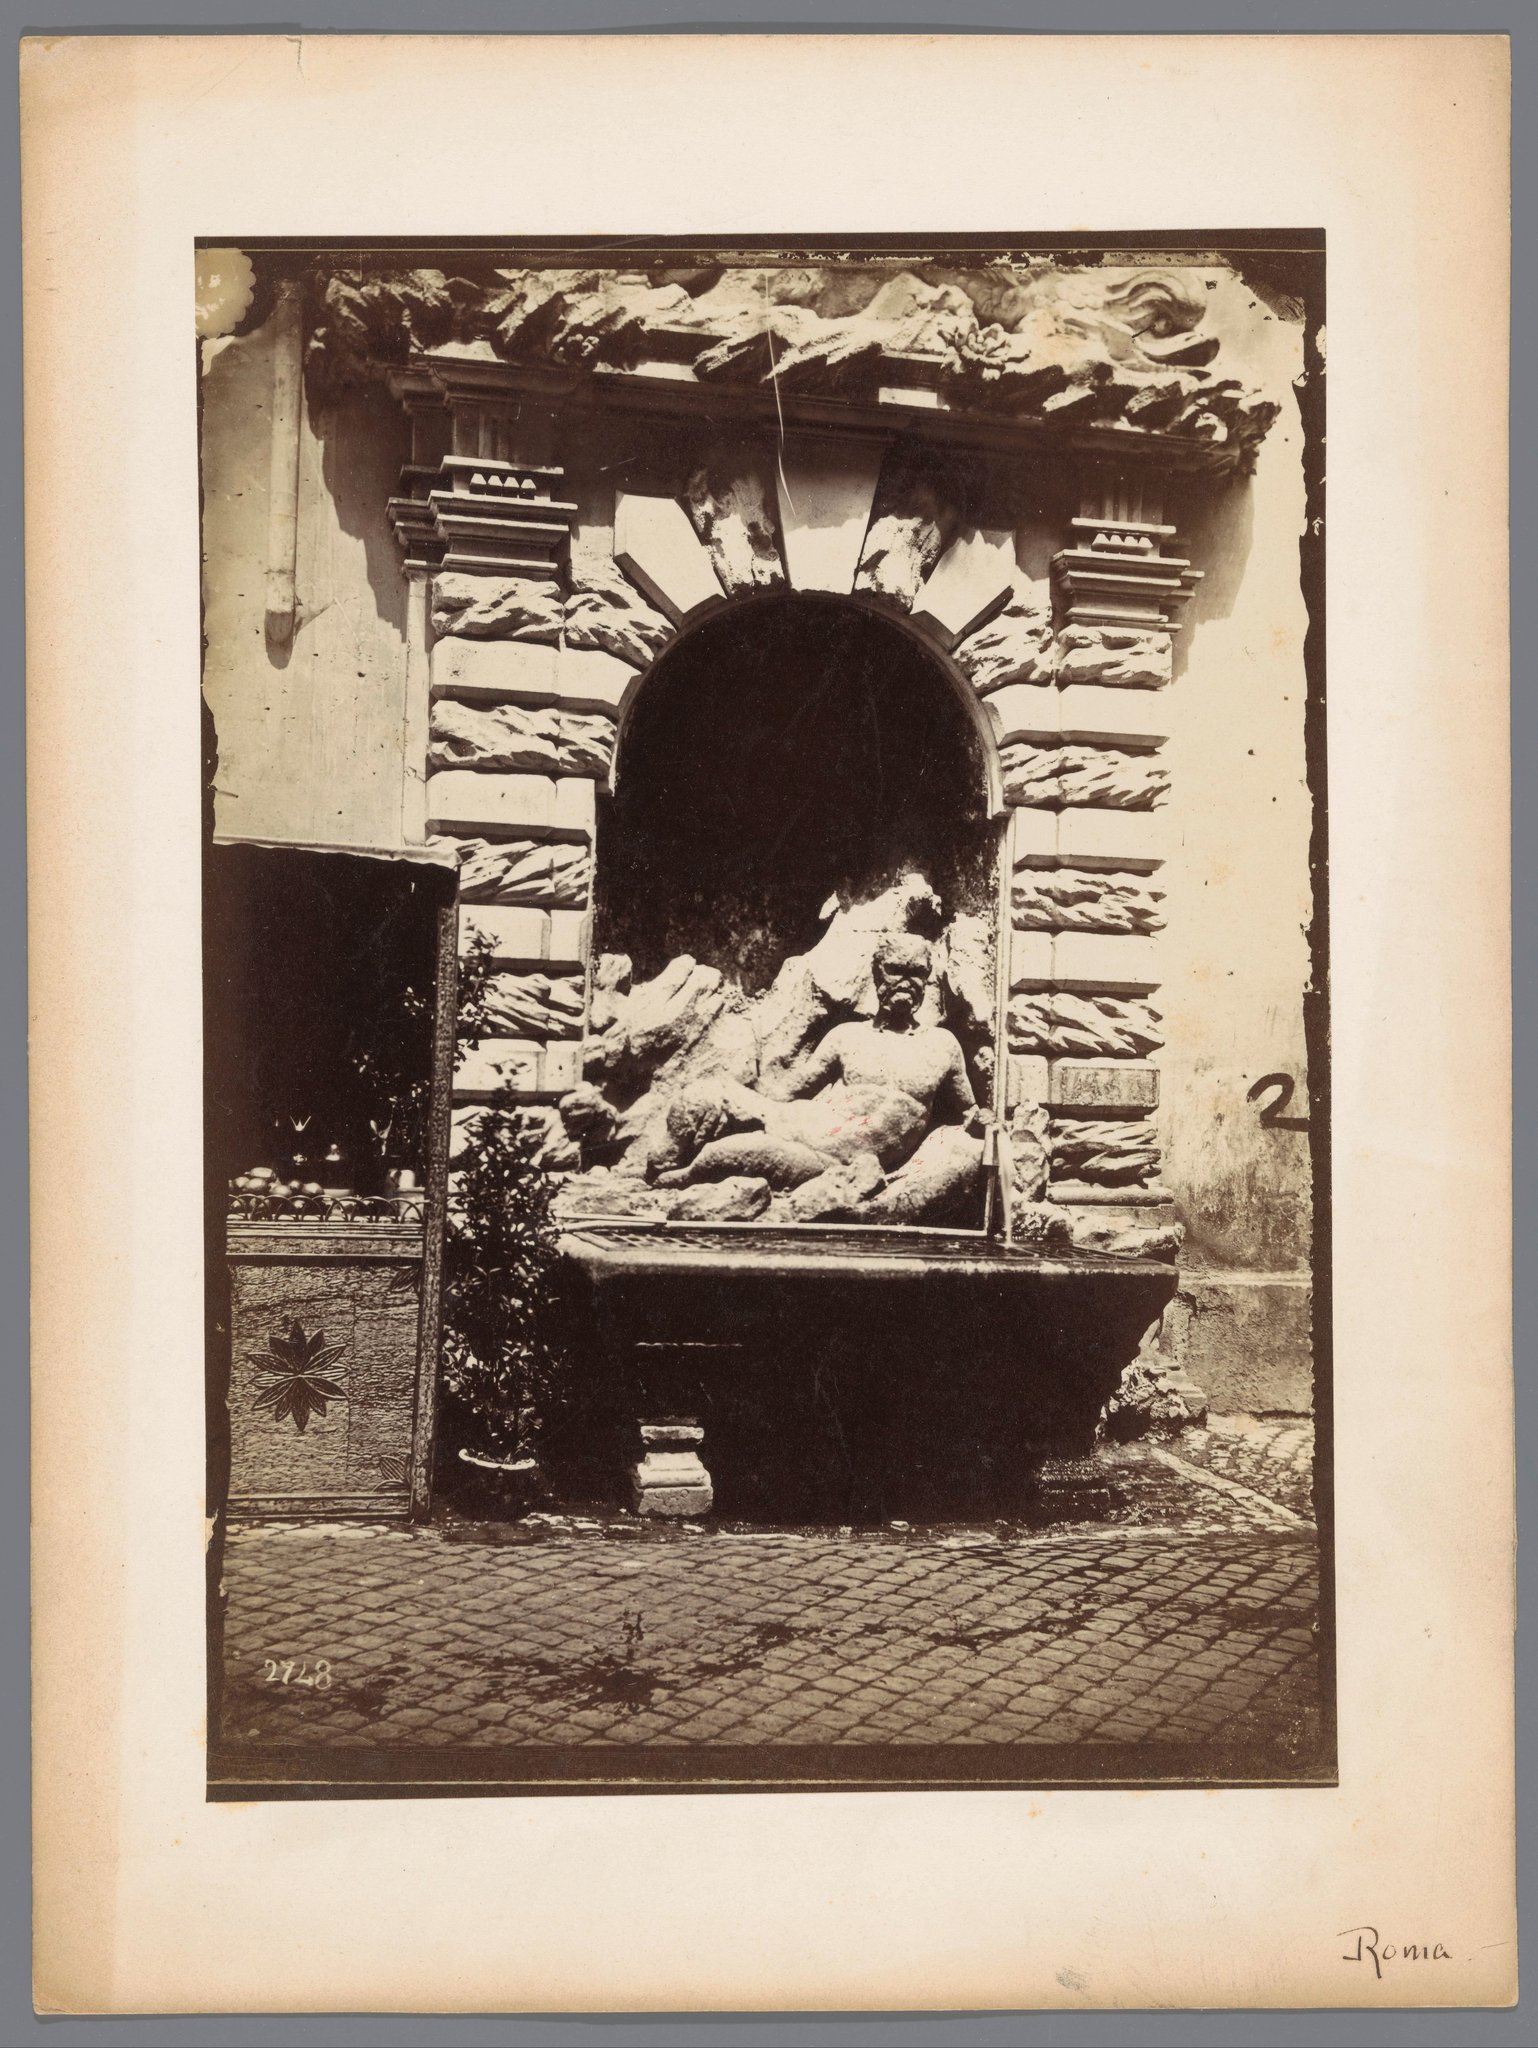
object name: photograph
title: Gezicht op Il Babuino te Rome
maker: gustave eugène chauffourier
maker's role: fotograaf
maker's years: 1845-1919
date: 1875-1900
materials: photographic support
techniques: albumen print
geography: rome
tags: (story of) silenus, sculpture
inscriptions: collector's mark: Lugt 3937, inscription: ‘Roma’, number: ‘2748’